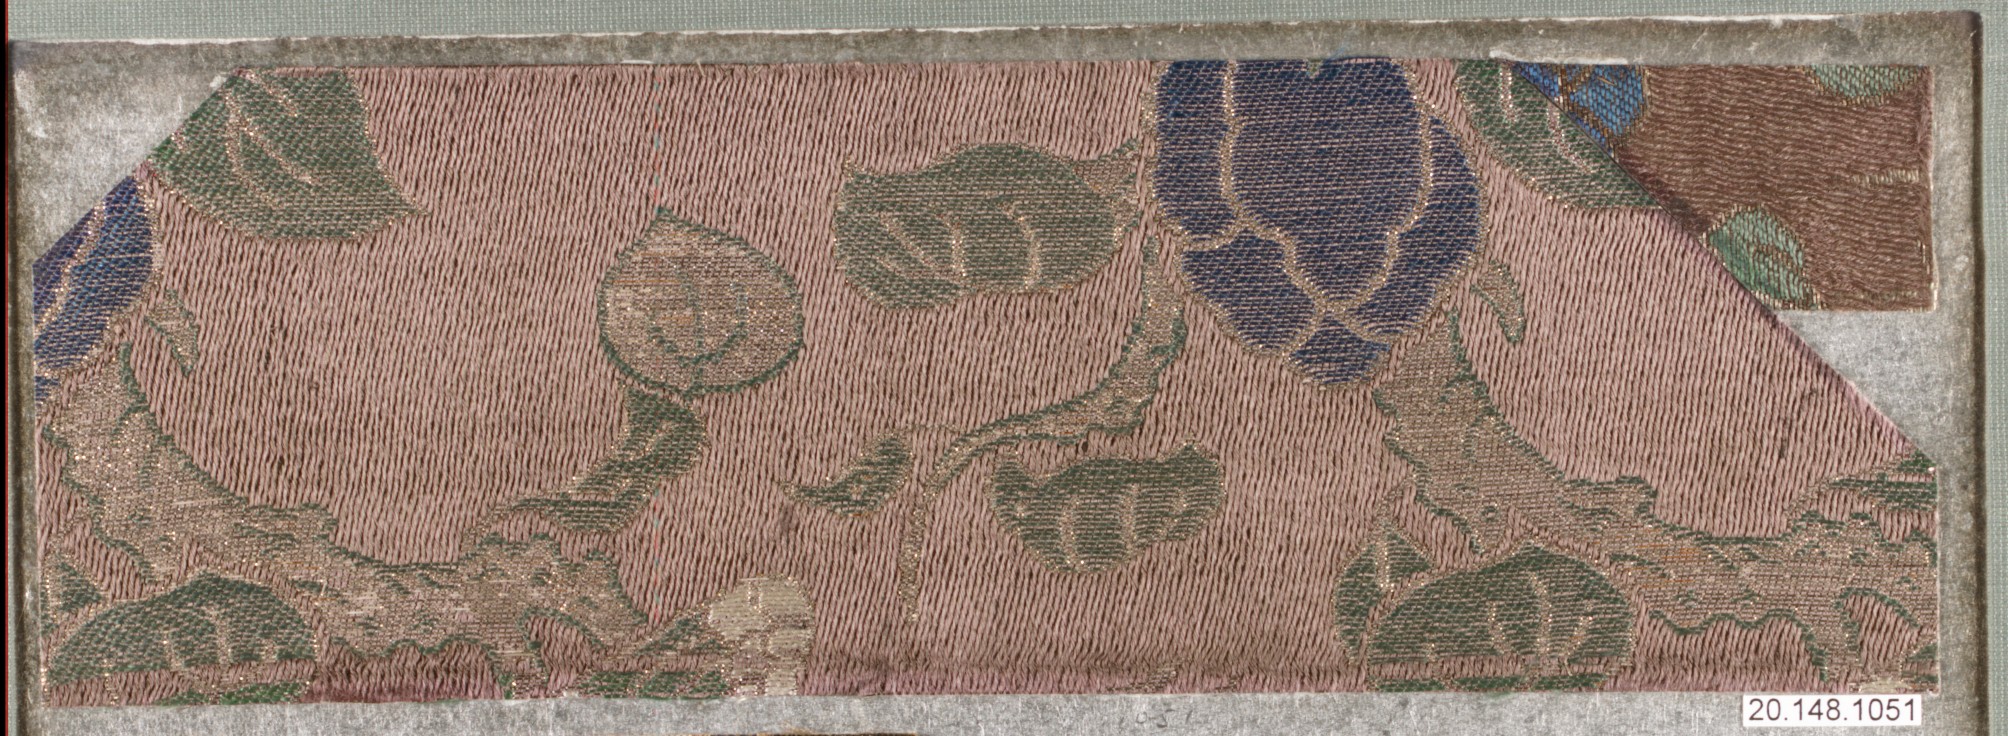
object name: piece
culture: japanese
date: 1701-1800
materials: silk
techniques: compound weave